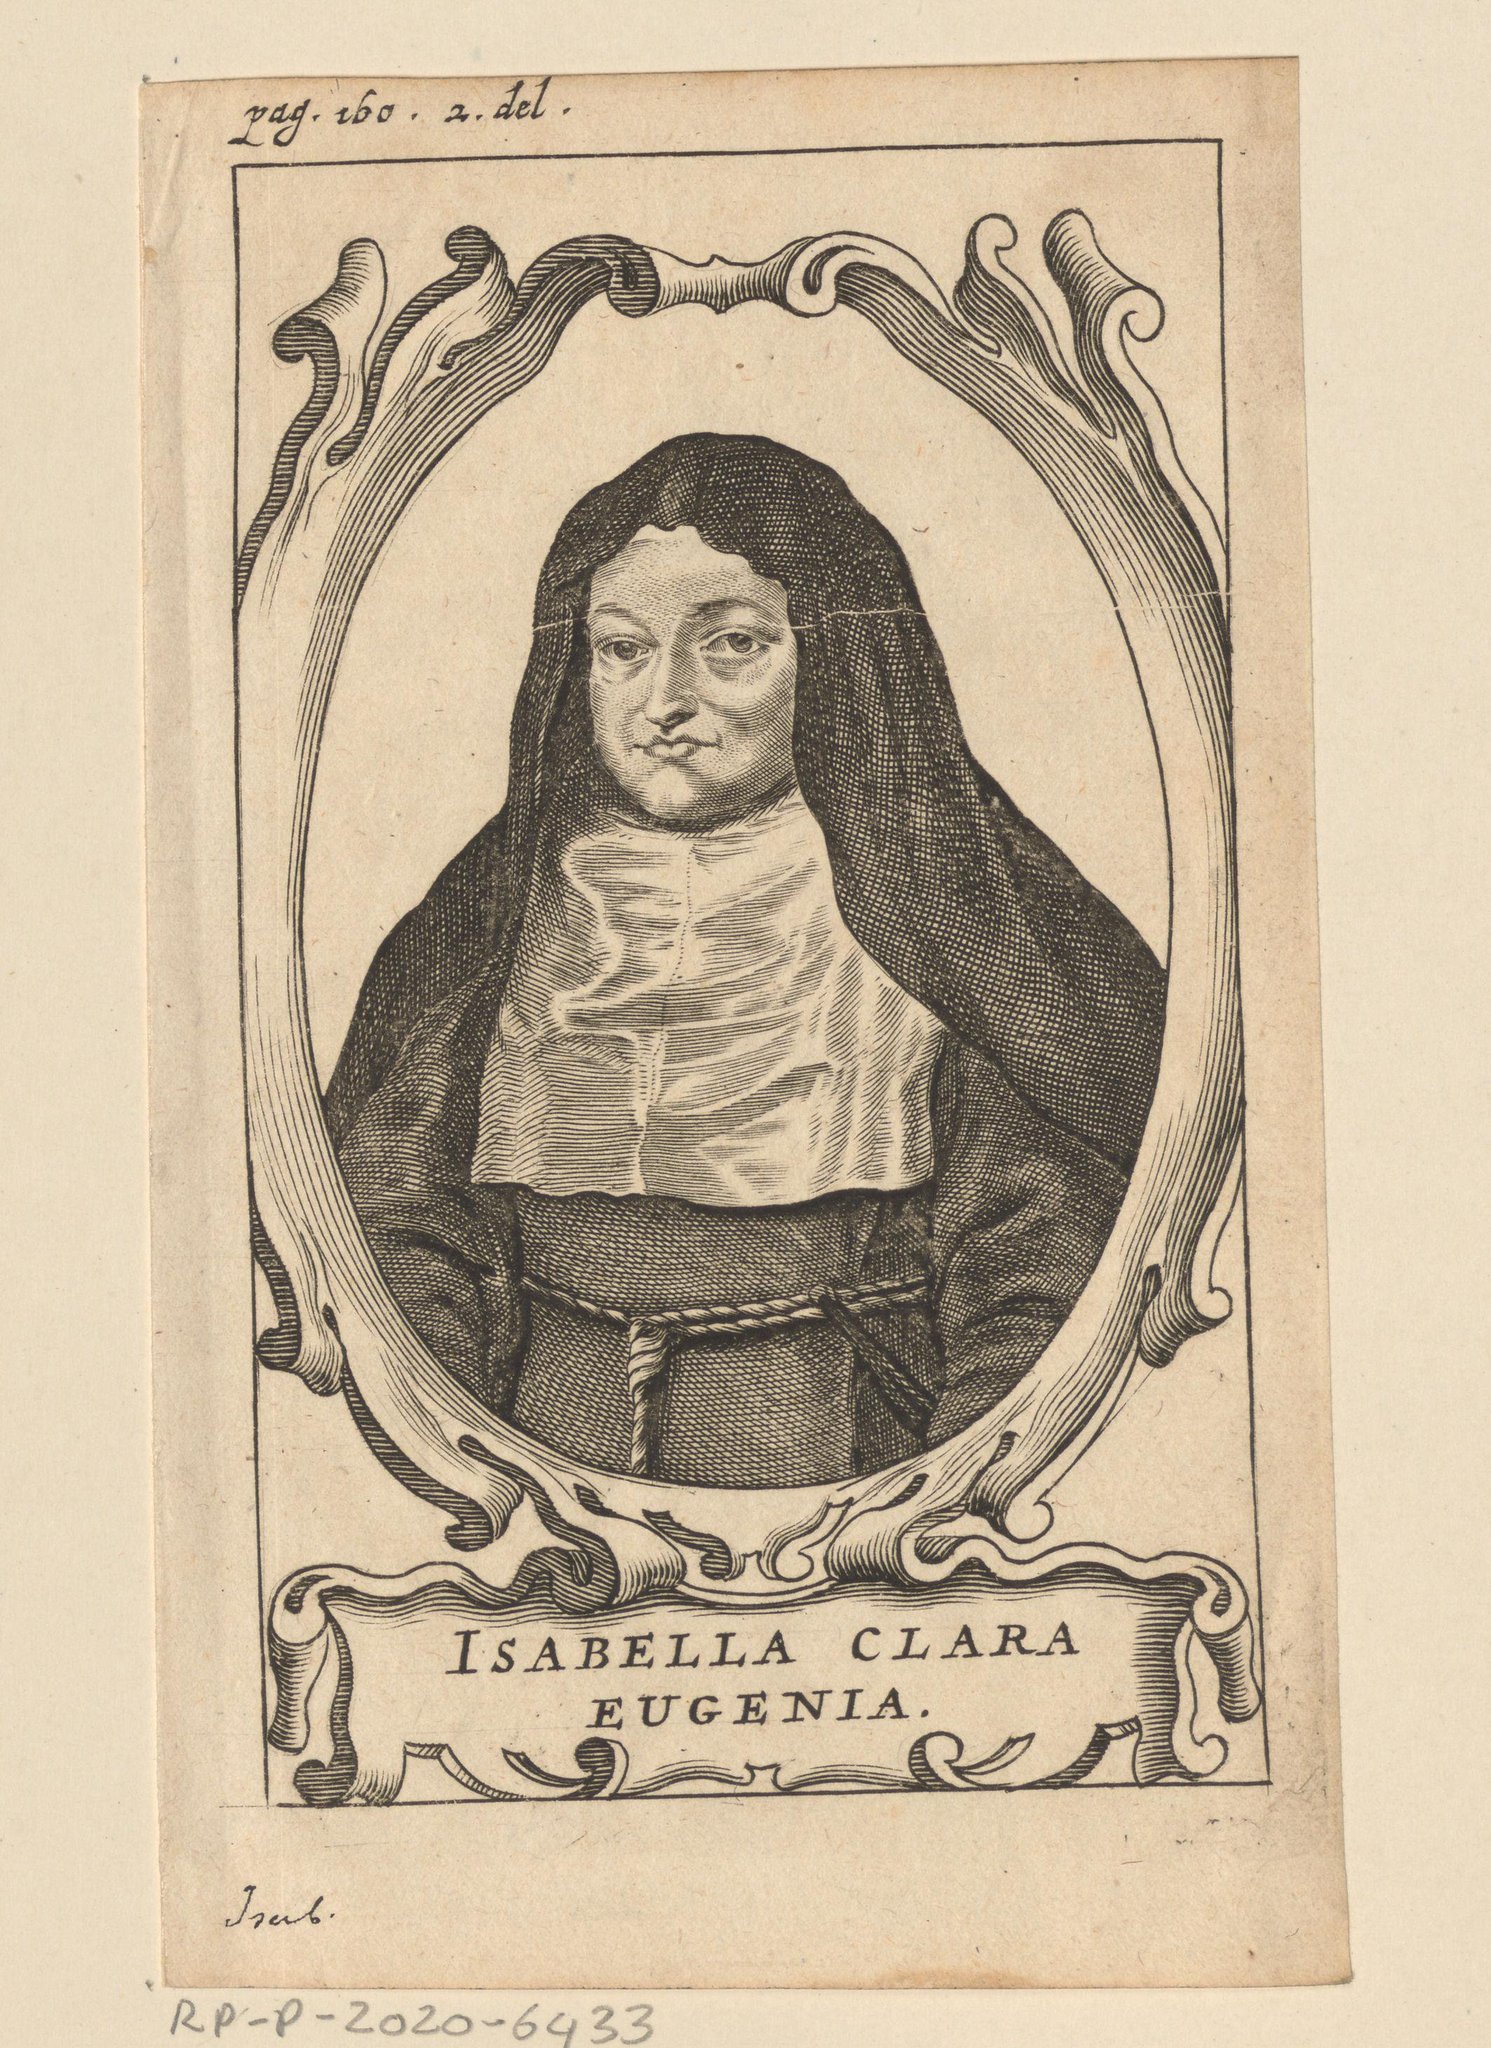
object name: print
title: Portret van Isabella Clara Eugenia, infante van Spanje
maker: Anonymous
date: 1621-1700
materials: paper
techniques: engraving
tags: infante van spanje isabella clara eugenia, historical persons - bb - woman, ruler, sovereign - bb - female ruler